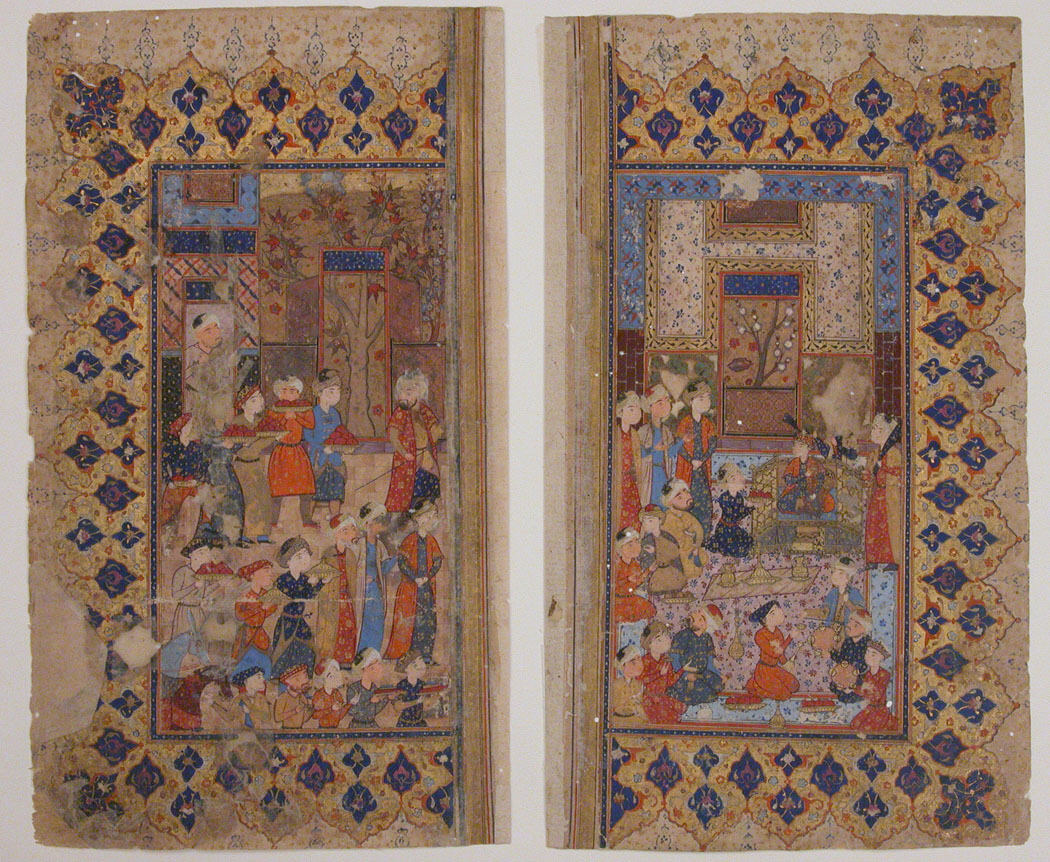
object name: folio from an illustrated manuscript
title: "Enthronement of a Young Prince (Shapur II?)", Folio from a Yusuf and Zulaikha of Jami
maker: maulana nur al-din `abd al-rahman jami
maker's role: author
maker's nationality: iranian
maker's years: 1414-1492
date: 1551-1600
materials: gold, paper, watercolor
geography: iran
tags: princes,men,ceremony